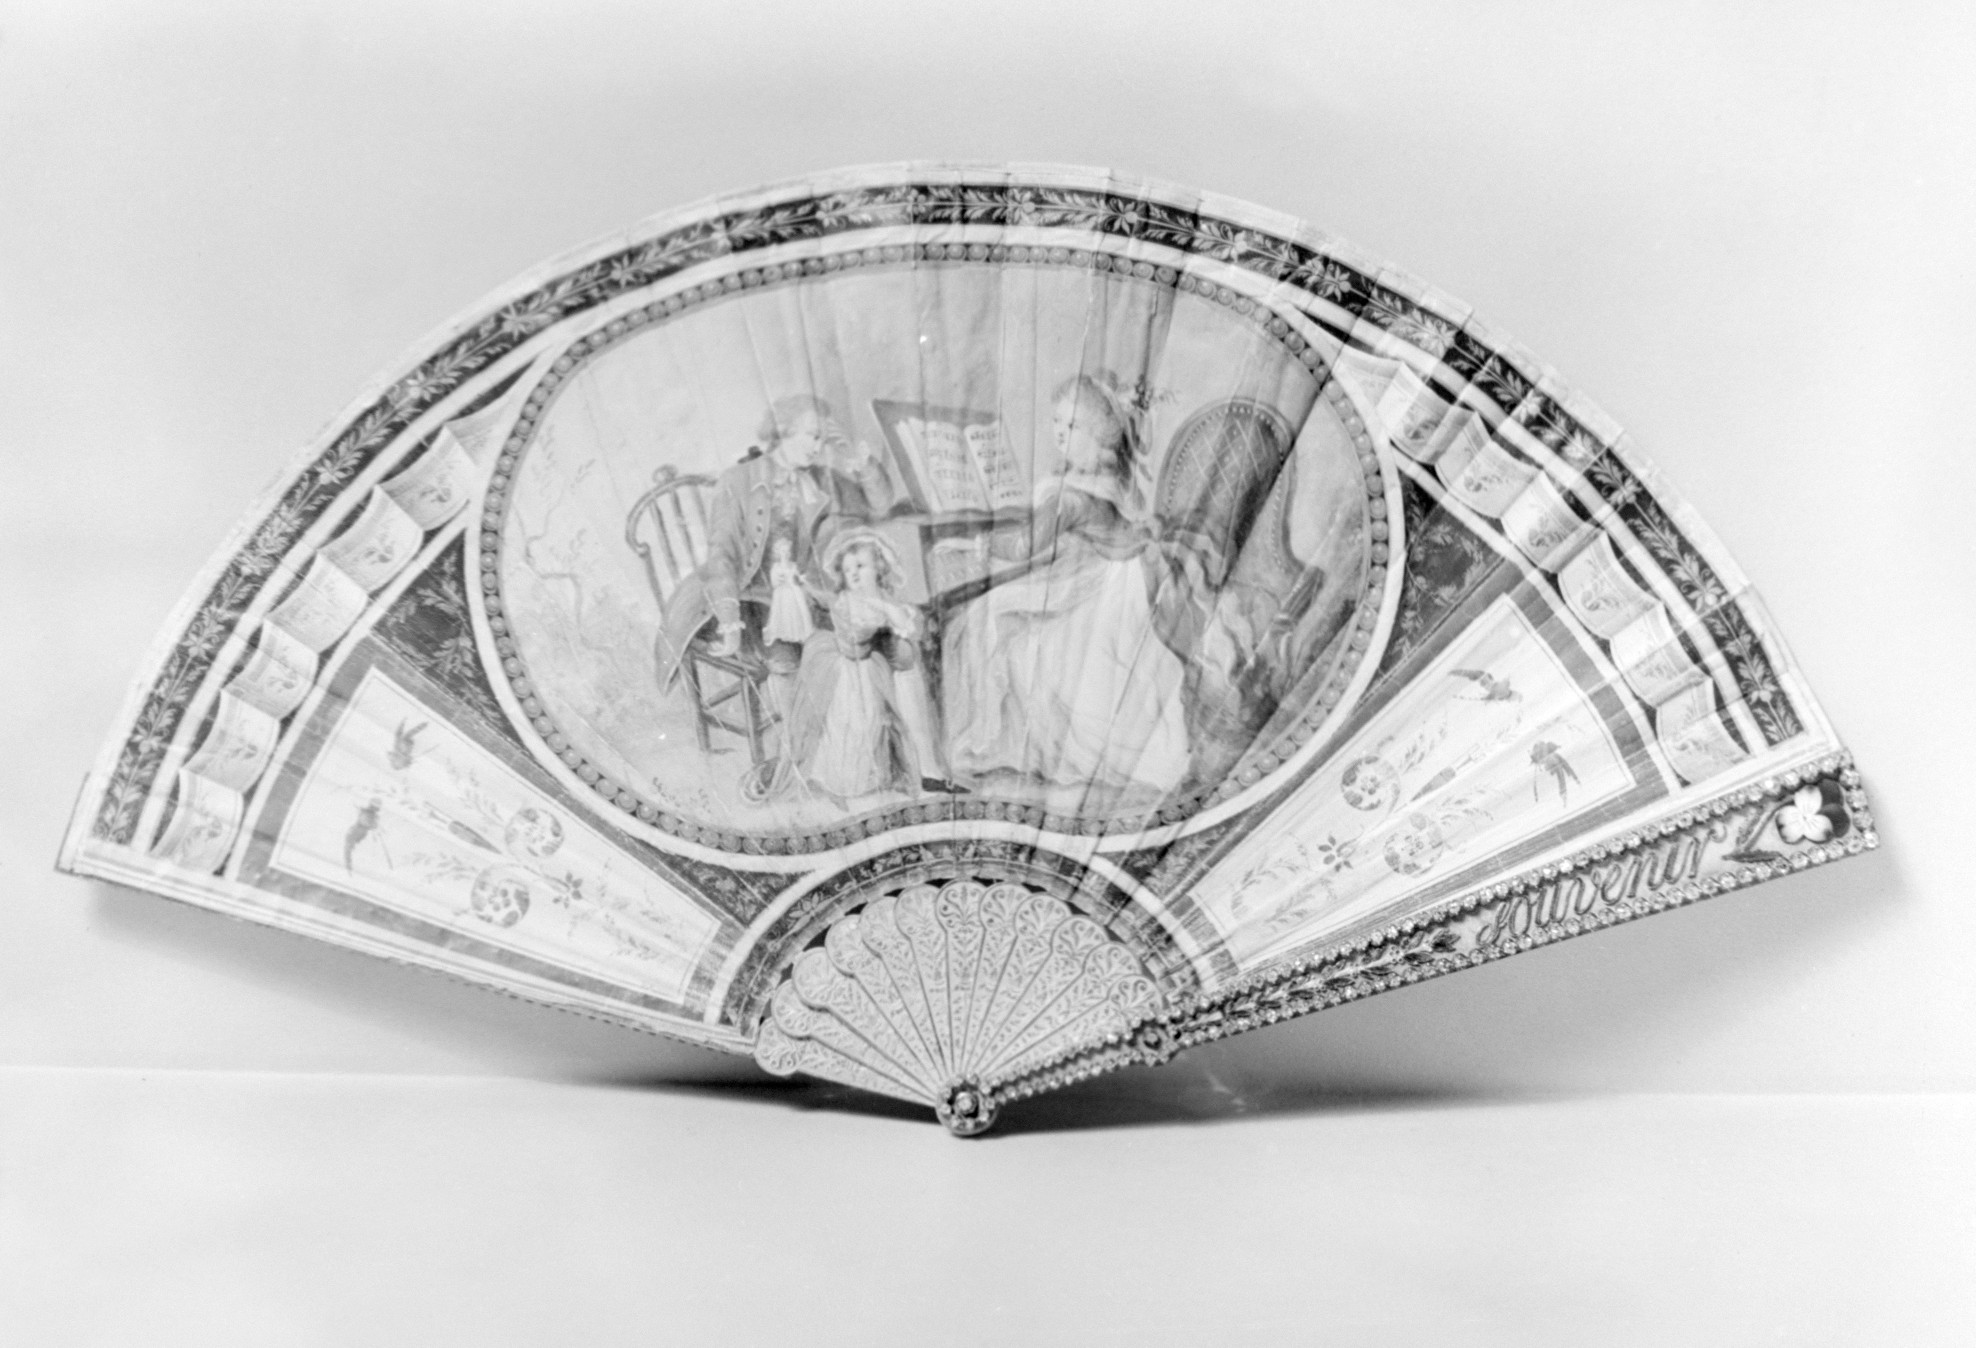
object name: fan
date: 1780-1785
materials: diamond, enamel, gold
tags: musical instruments,girls,men,women,dolls